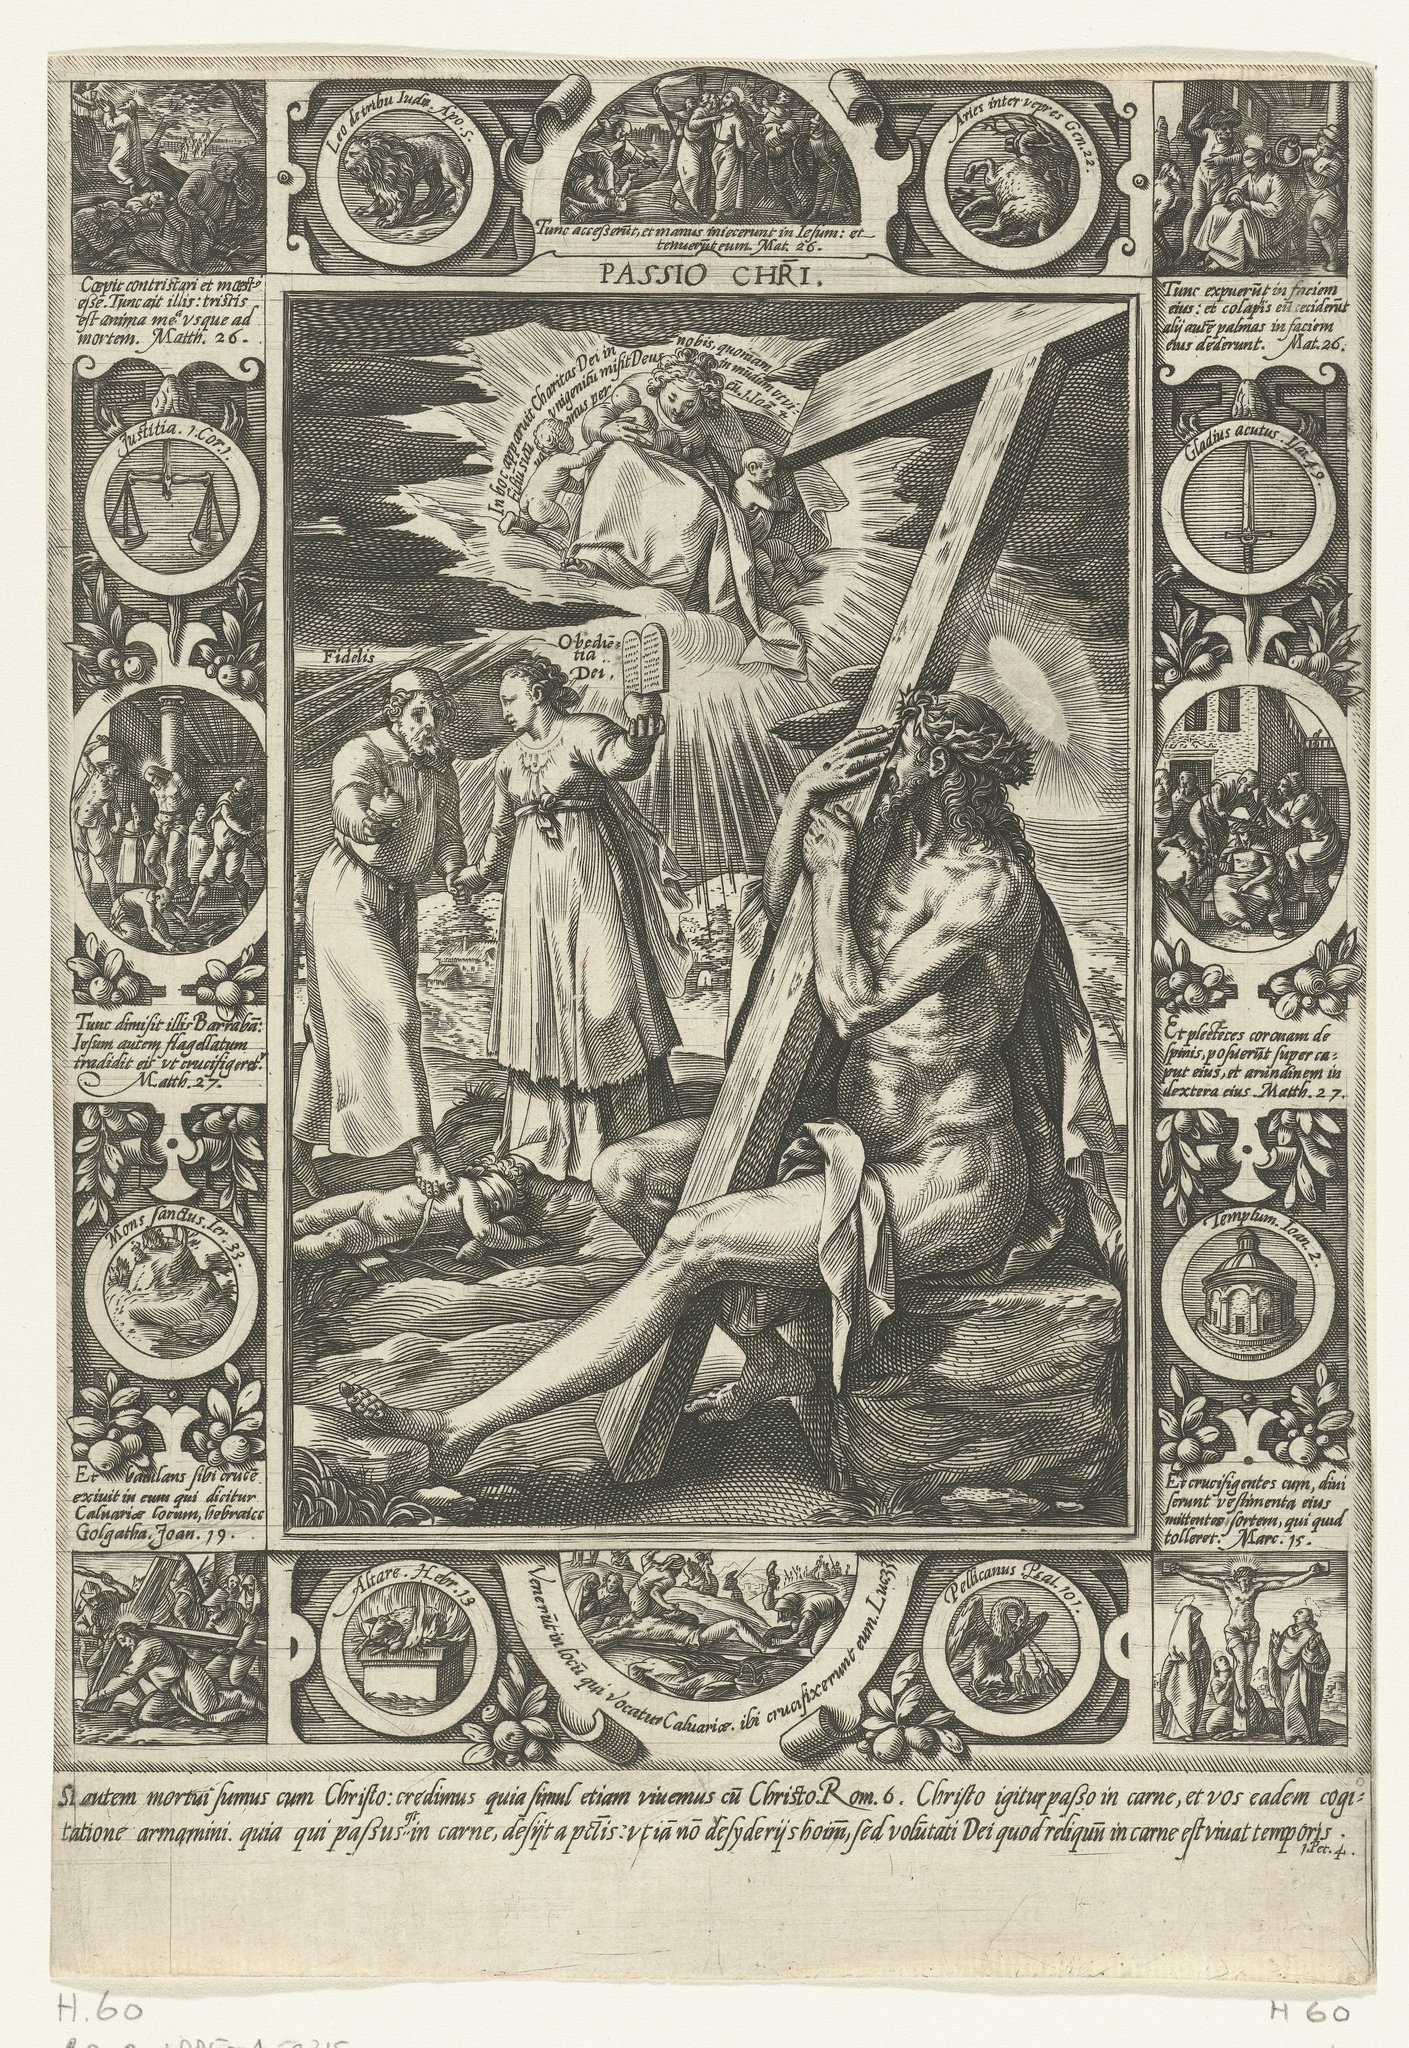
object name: print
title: Passie van Christus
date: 1578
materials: paper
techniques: engraving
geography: antwerp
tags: bible (+ christ bearded), symbols and prefigurations of christ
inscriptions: collector's mark: Lugt 2228a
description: Christus, vrijwel naakt, zittend met het kruis in de armen. Rondom de voorstelling een omlijsting met diverse scènes uit het passieverhaal gecombineerd met allegorische elementen. In de marge onderaan twee regels Latijn. Deze prent is onderdeel van een serie van zes allegorische scènes uit het leven van Christus.